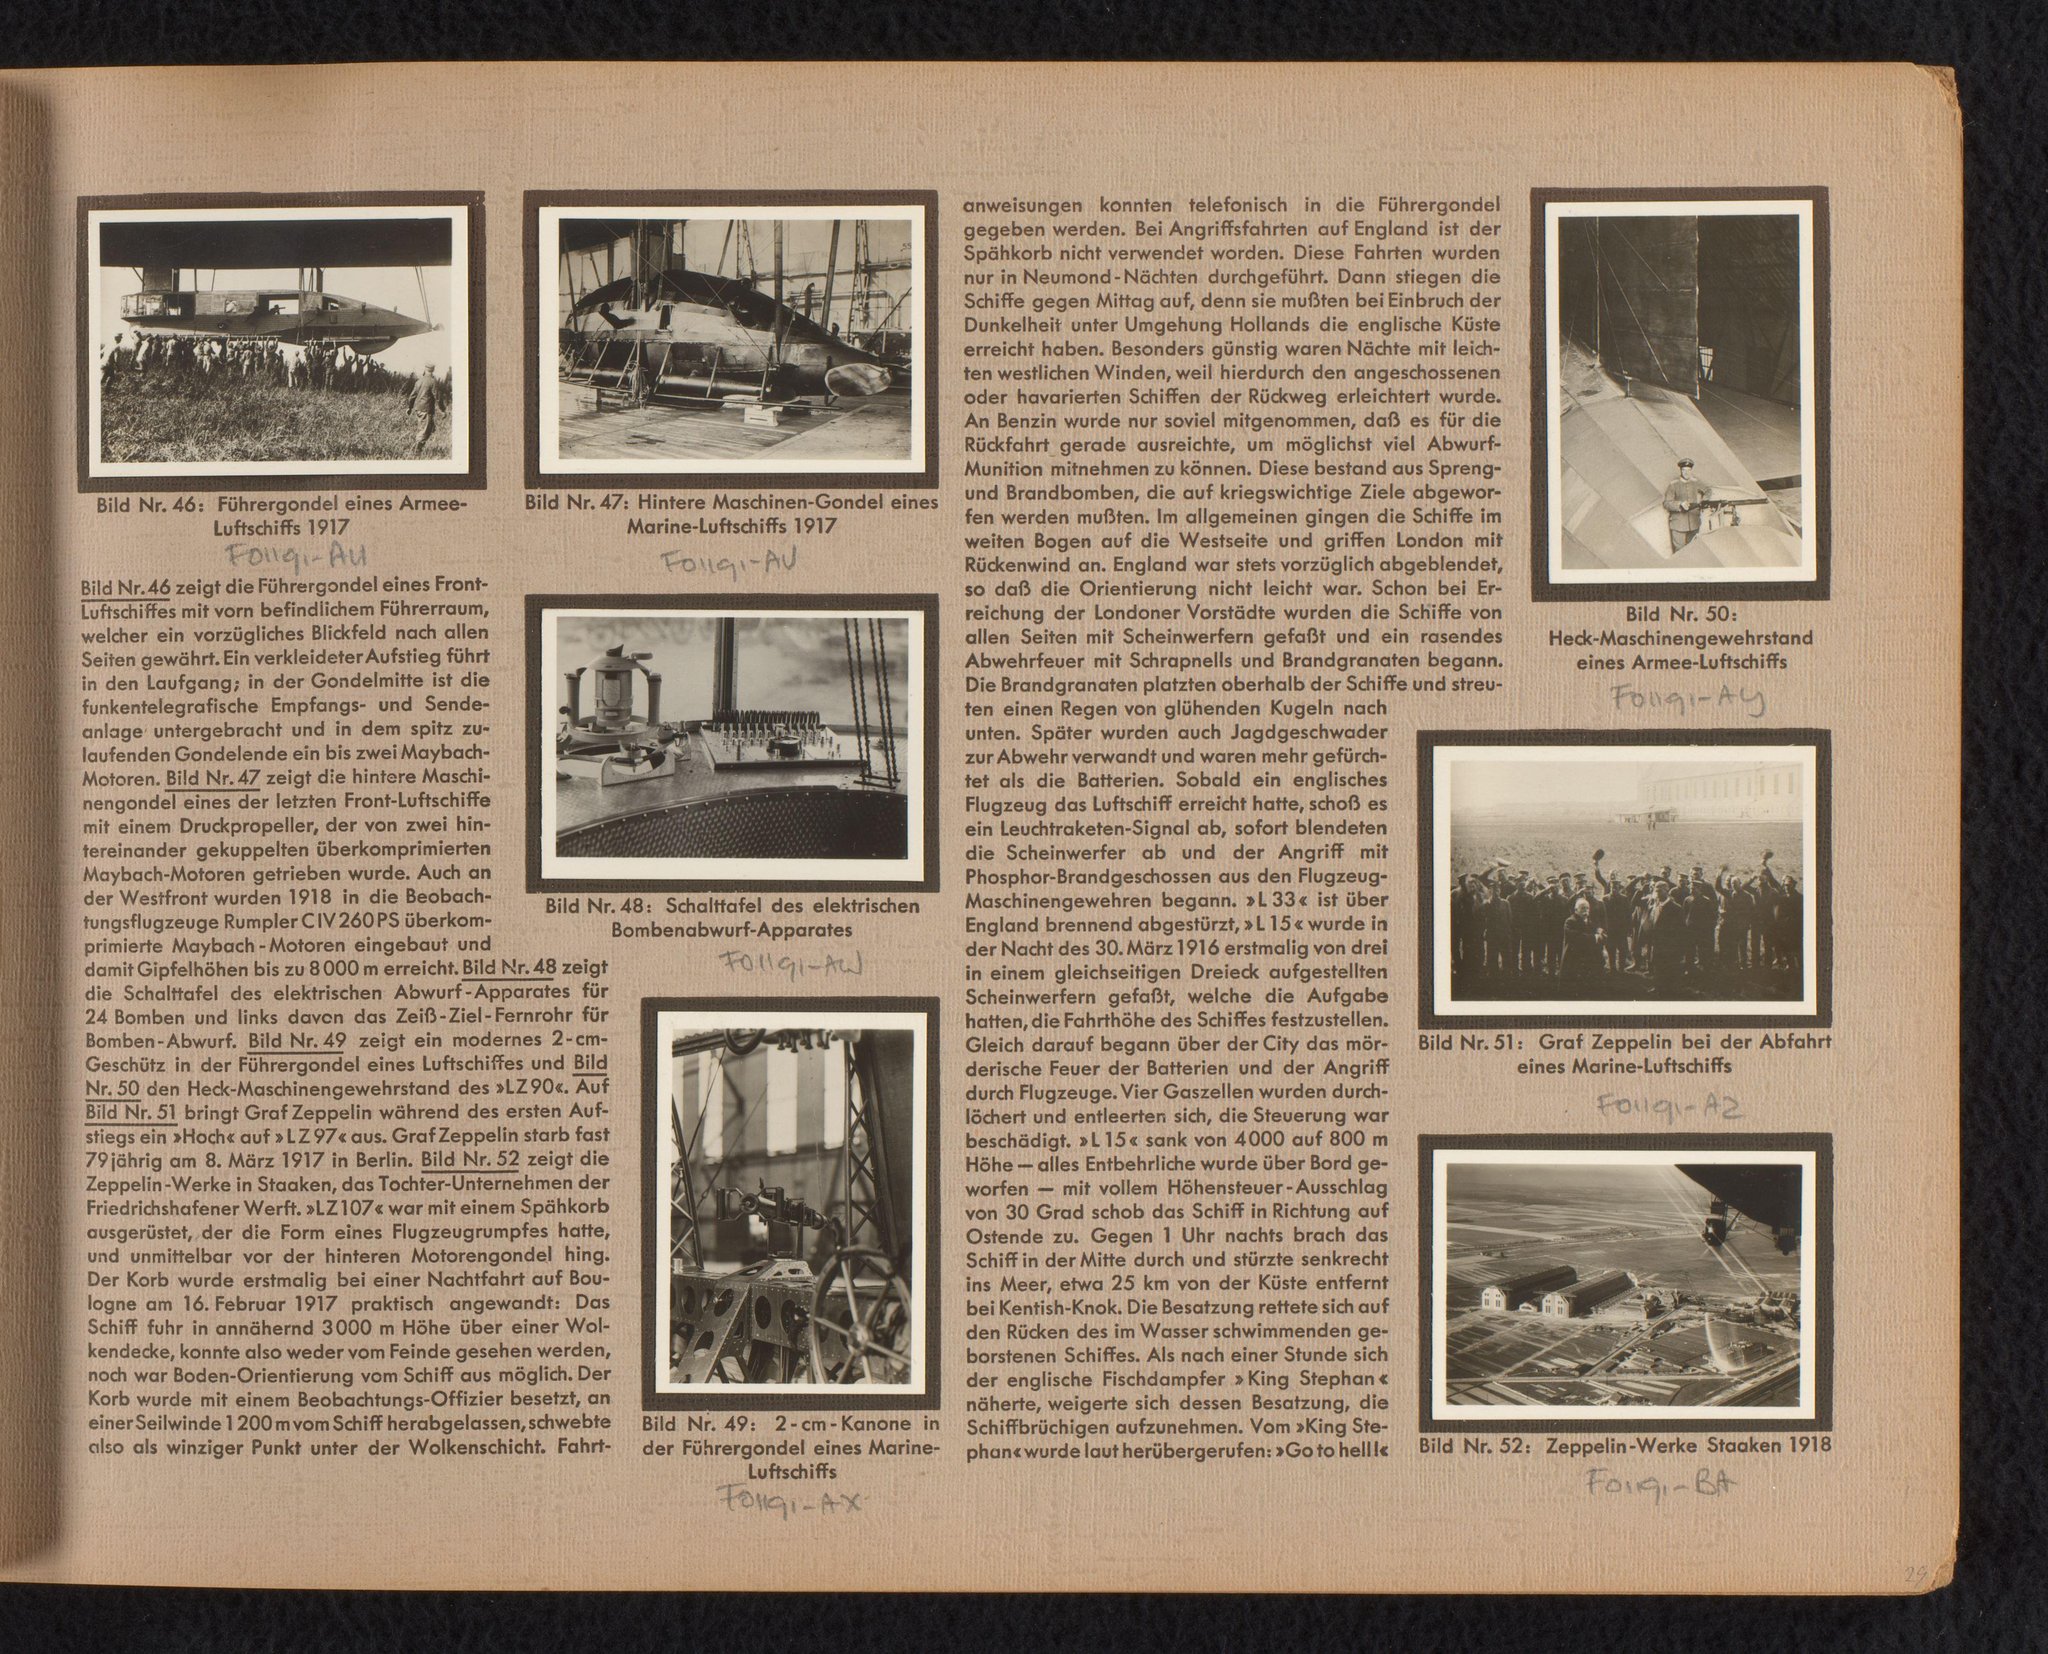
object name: scrapbook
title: Verschillende onderdelen van een zeppelin voor oorlogsvoering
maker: Anonymous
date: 1917-1918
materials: paper, photographic support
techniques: gelatin silver print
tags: 46c35 airship, zeppelin, historical persons, (military) uniforms, germany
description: Zeven foto's van onder meer zeppelins tijdens de Eerste Wereldoorlog en een groepsportret van soldaten met Graf Zeppelin. Alle foto's zijn voorzien van een nummer en titel. Deze pagina maakt deel uit van een album.